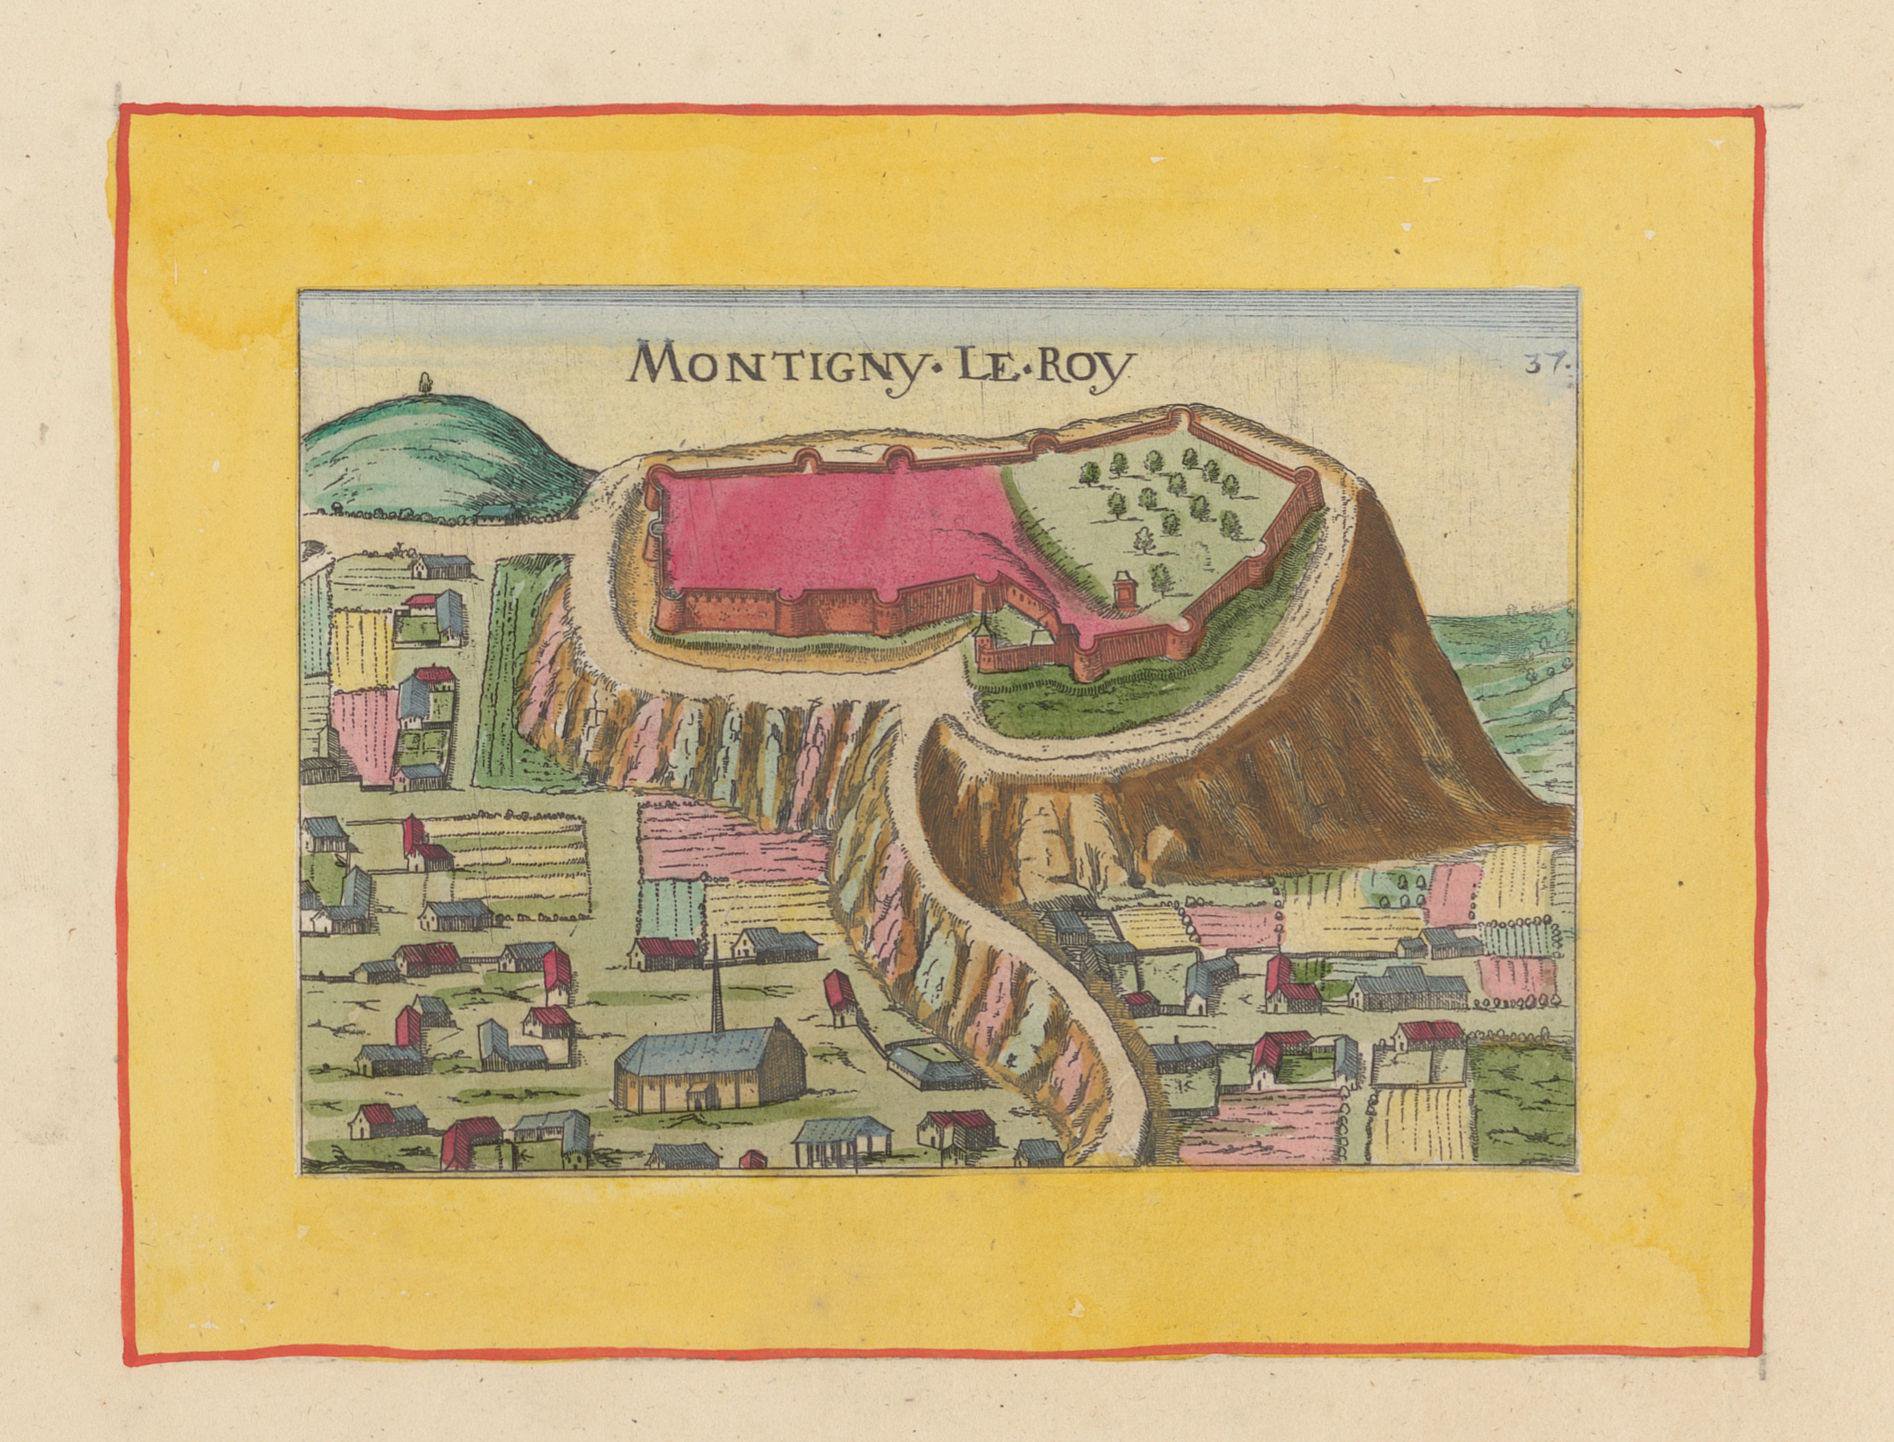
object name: print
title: Montigy-le-Roy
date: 1638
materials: paper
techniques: engraving, hand coloring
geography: paris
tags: maps of cities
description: Prent uit: Tassin, Christophe. Les plans et profils de toutes les principales villes et lieux considérables de France (...). Parijs: Michel van Lochom, 1638, plattegrond 37 uit het deel 'Champagne'.